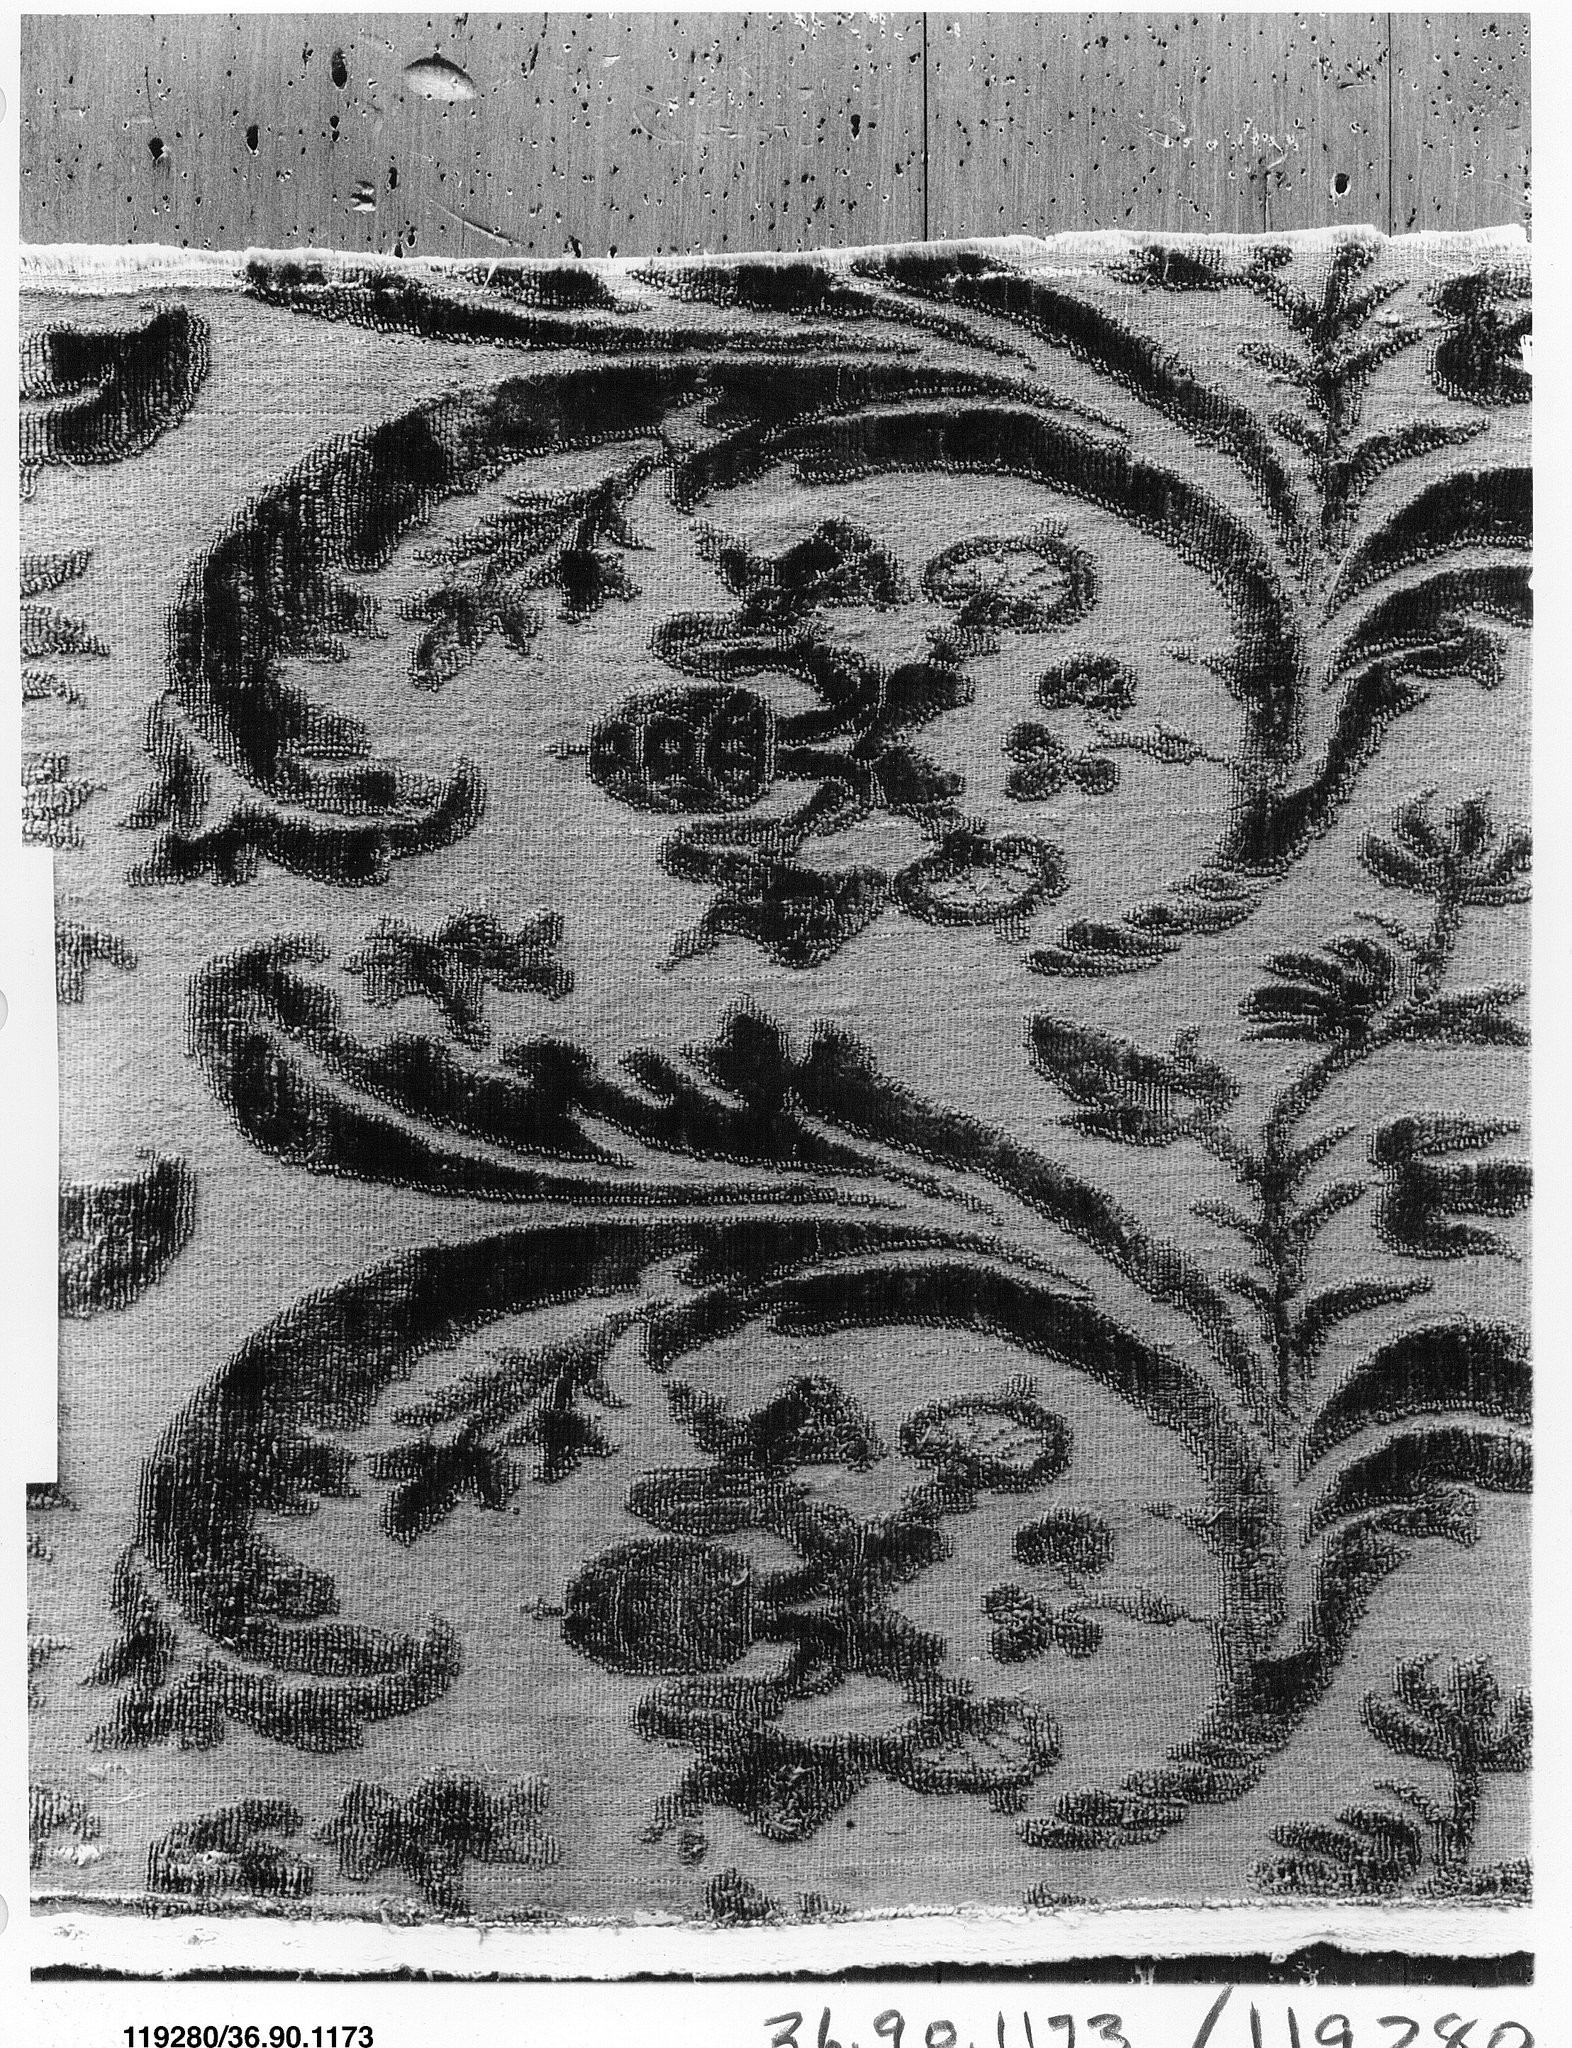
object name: piece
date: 1701-1733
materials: silk